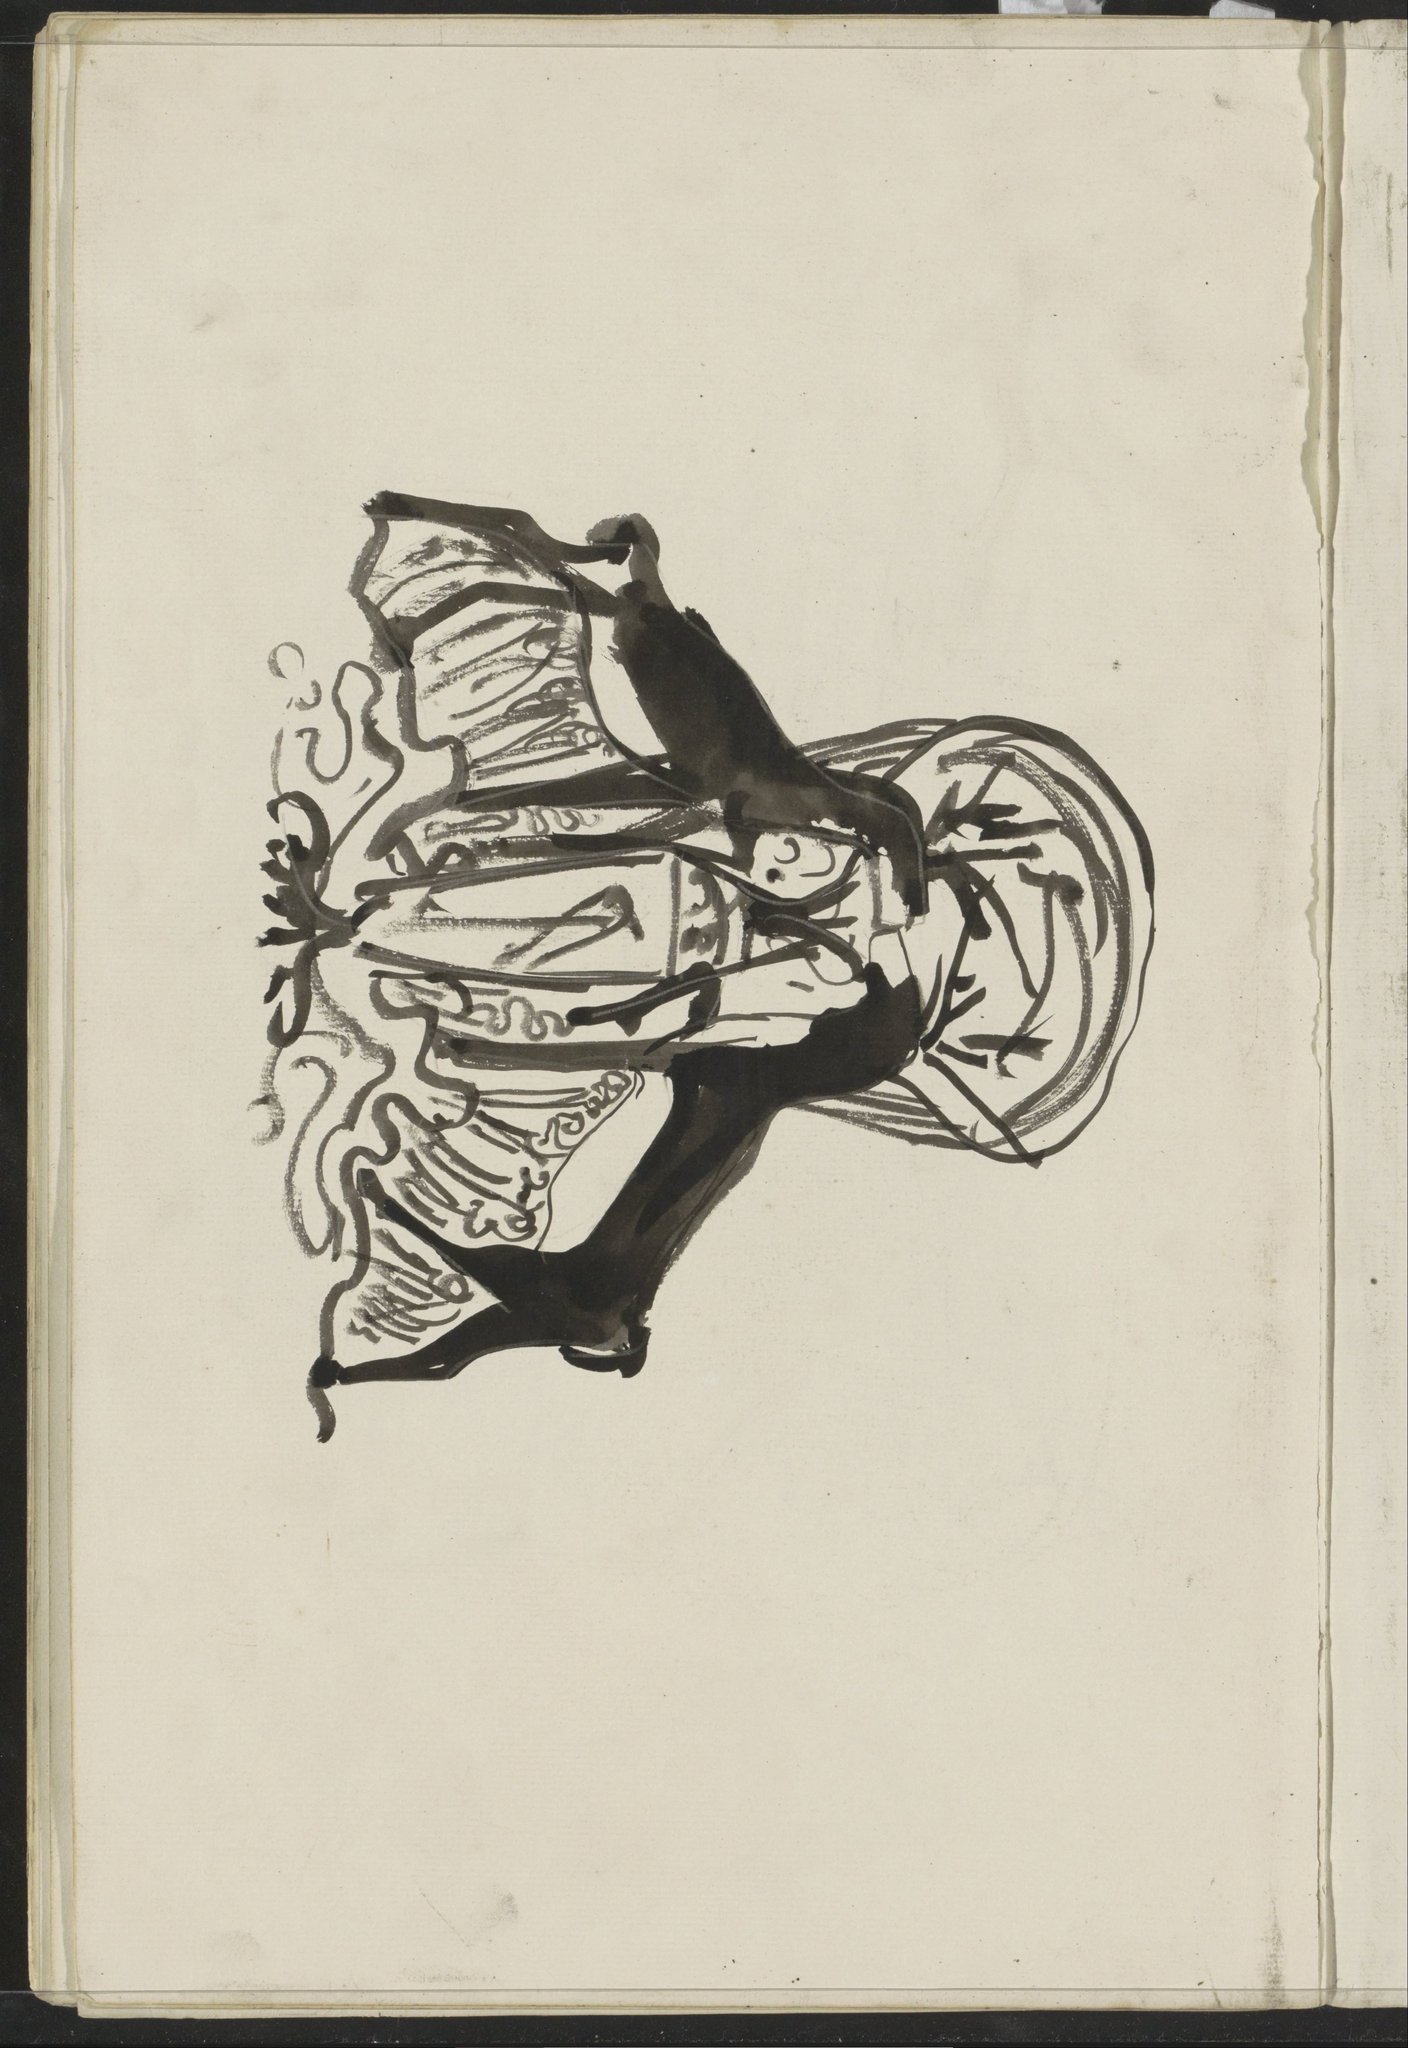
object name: sketchbook leaf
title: Siermotief met twee herten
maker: carel adolph lion cachet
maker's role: draughtsman, print maker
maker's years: 1864-1945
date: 1897-1898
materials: ink, paper, pencil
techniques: brush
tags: hoofed animals: deer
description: Blad 28 verso uit een schetsboek met 29 bladen.